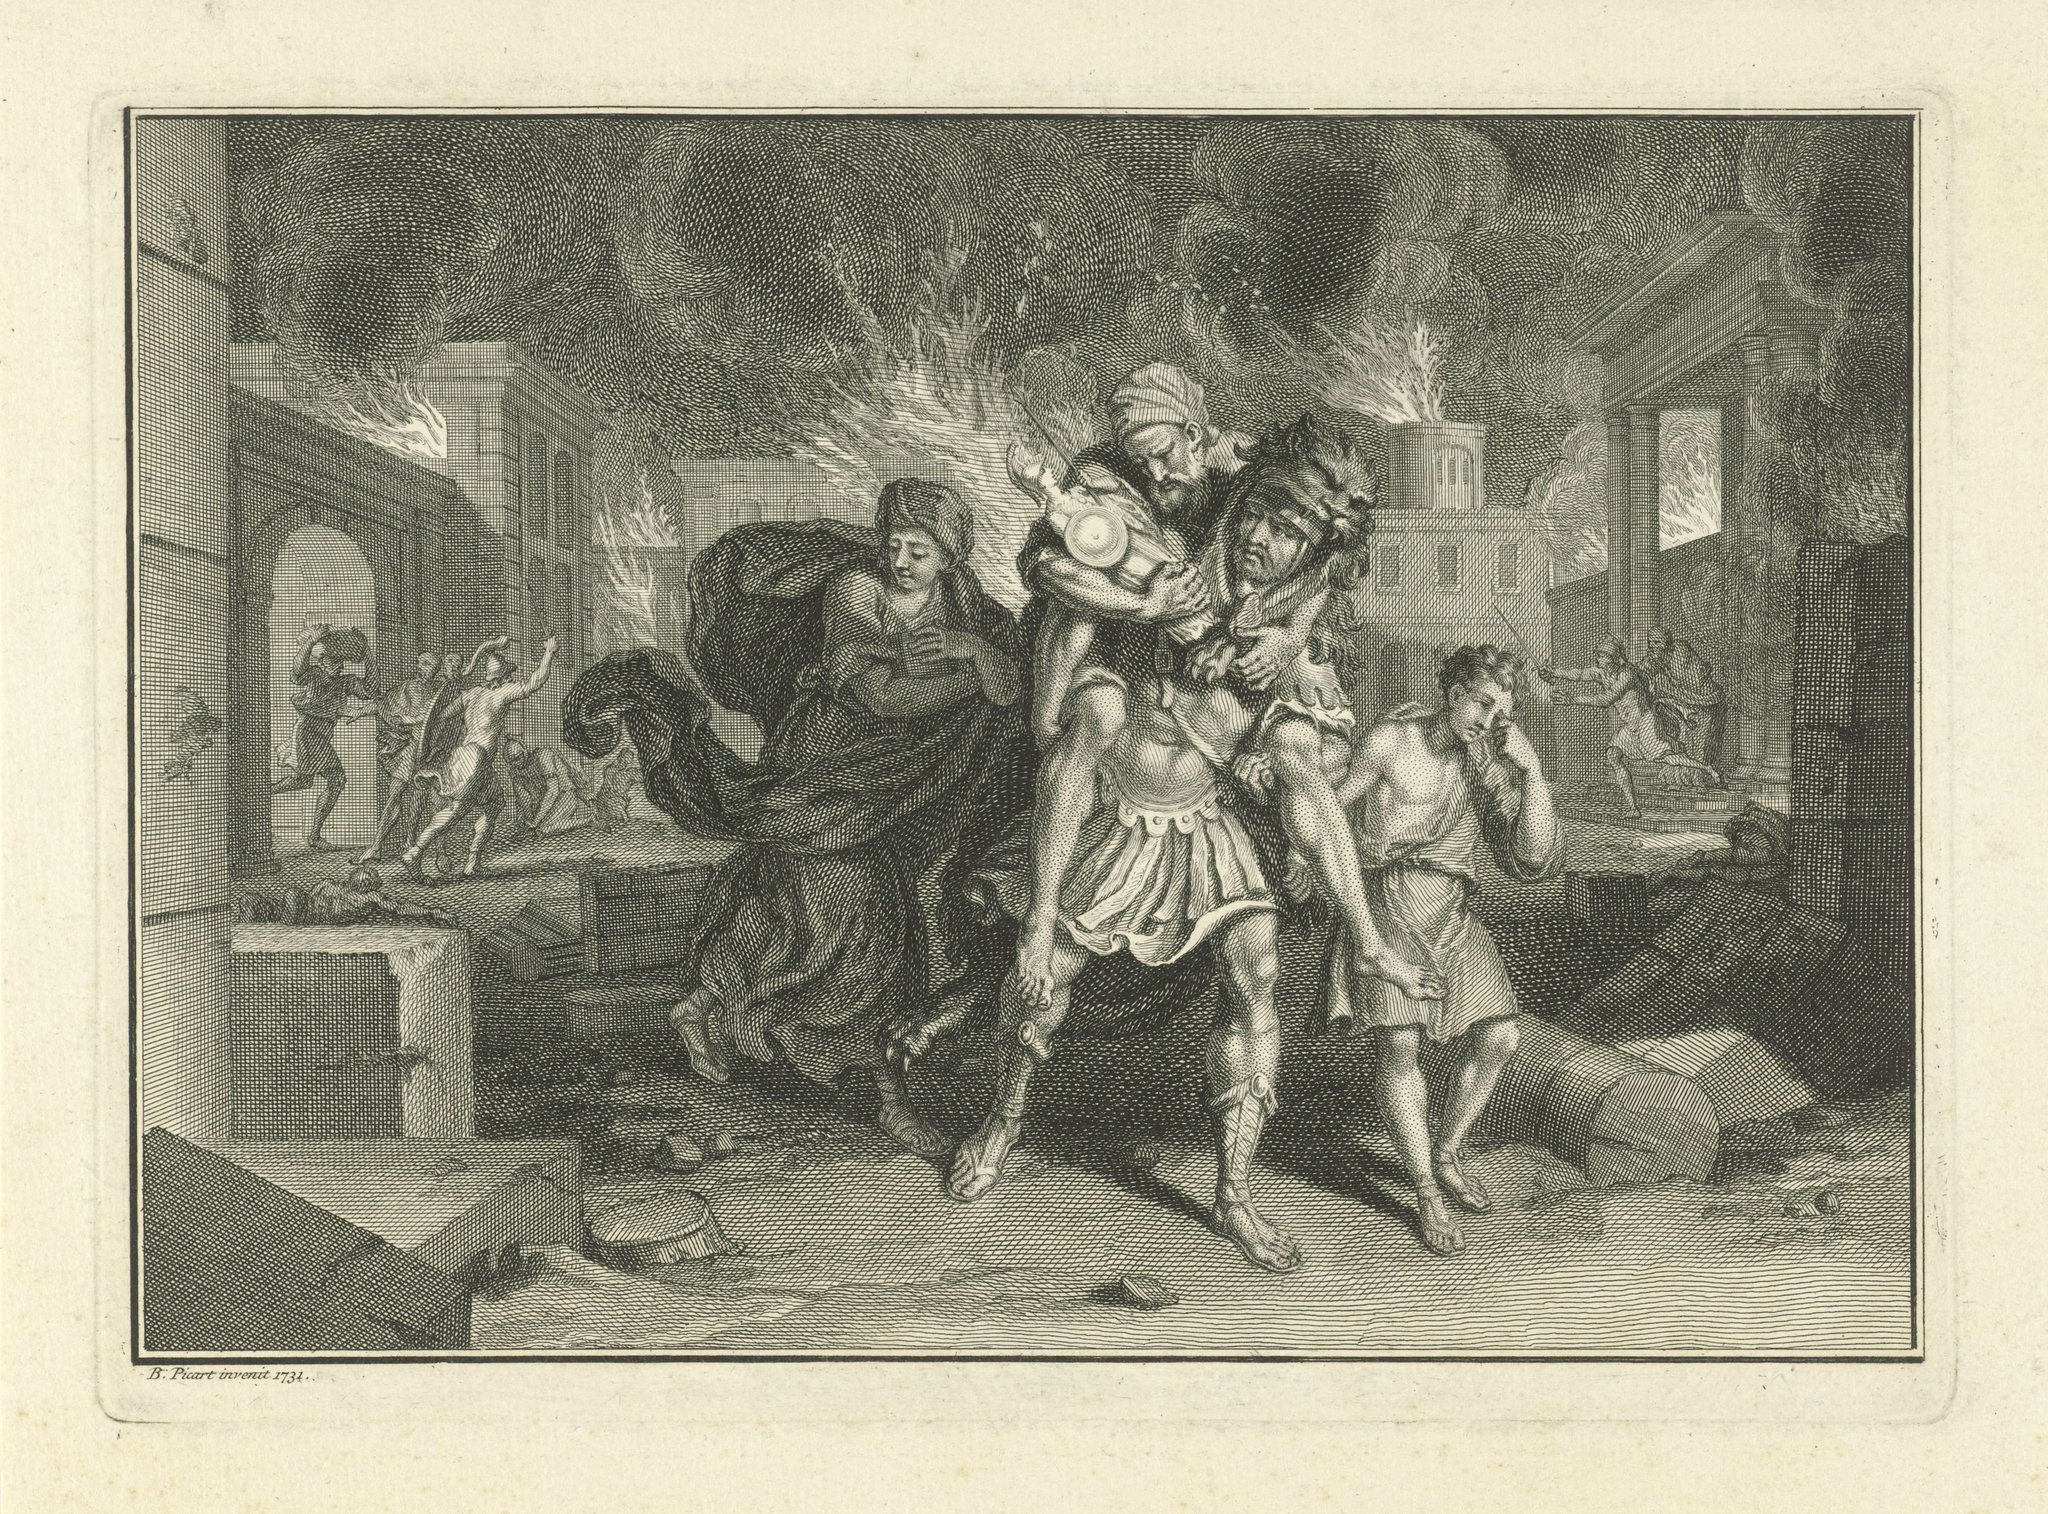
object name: print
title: Aeneas draagt zijn vader het brandende Troje uit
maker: bernard picart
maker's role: draughtsman, print maker, publisher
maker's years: 1673-1733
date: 1731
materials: paper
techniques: engraving, etching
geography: amsterdam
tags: 'pius aeneas': aeneas, leading ascanius, escapes from burning troy, carrying his father anchises with the penates; his wife creusa, who sets out with them, is lost on the way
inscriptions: date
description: Aeneas ontsnapt 's nachts uit het brandende Troje en draagt zijn vader Anchises op zijn rug de stad uit. Zijn zoon Ascanius houdt hij aan de hand. Zijn vrouw Creusa loopt nog achter hen aan. Met een lege marge.